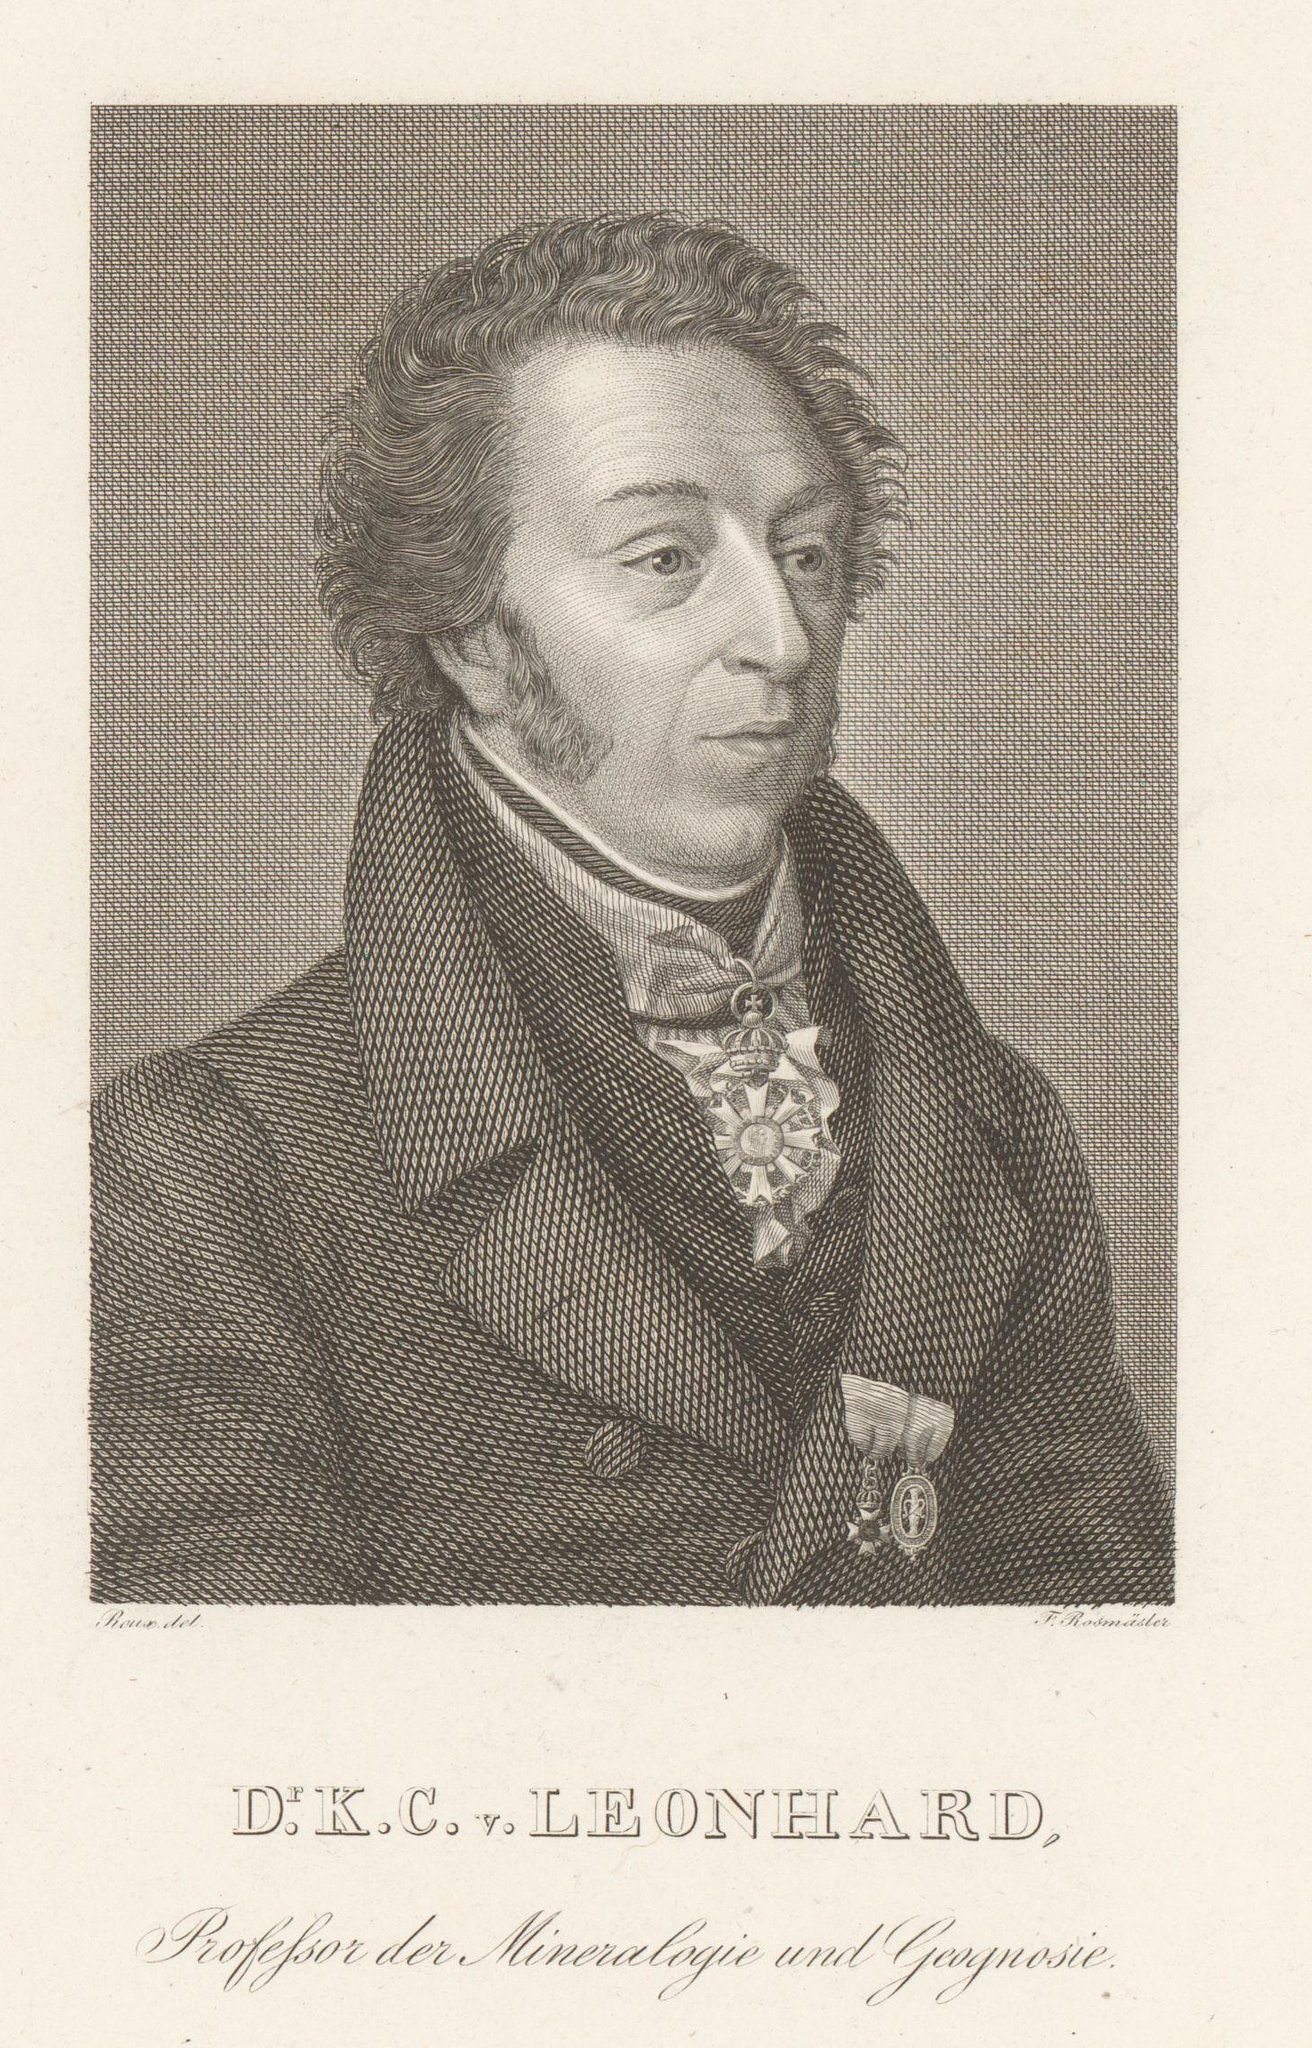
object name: print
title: Portret van Karl Cäsar von Leonhard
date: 1785-1858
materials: paper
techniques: engraving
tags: historical persons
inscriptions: collector's mark: Lugt 2228